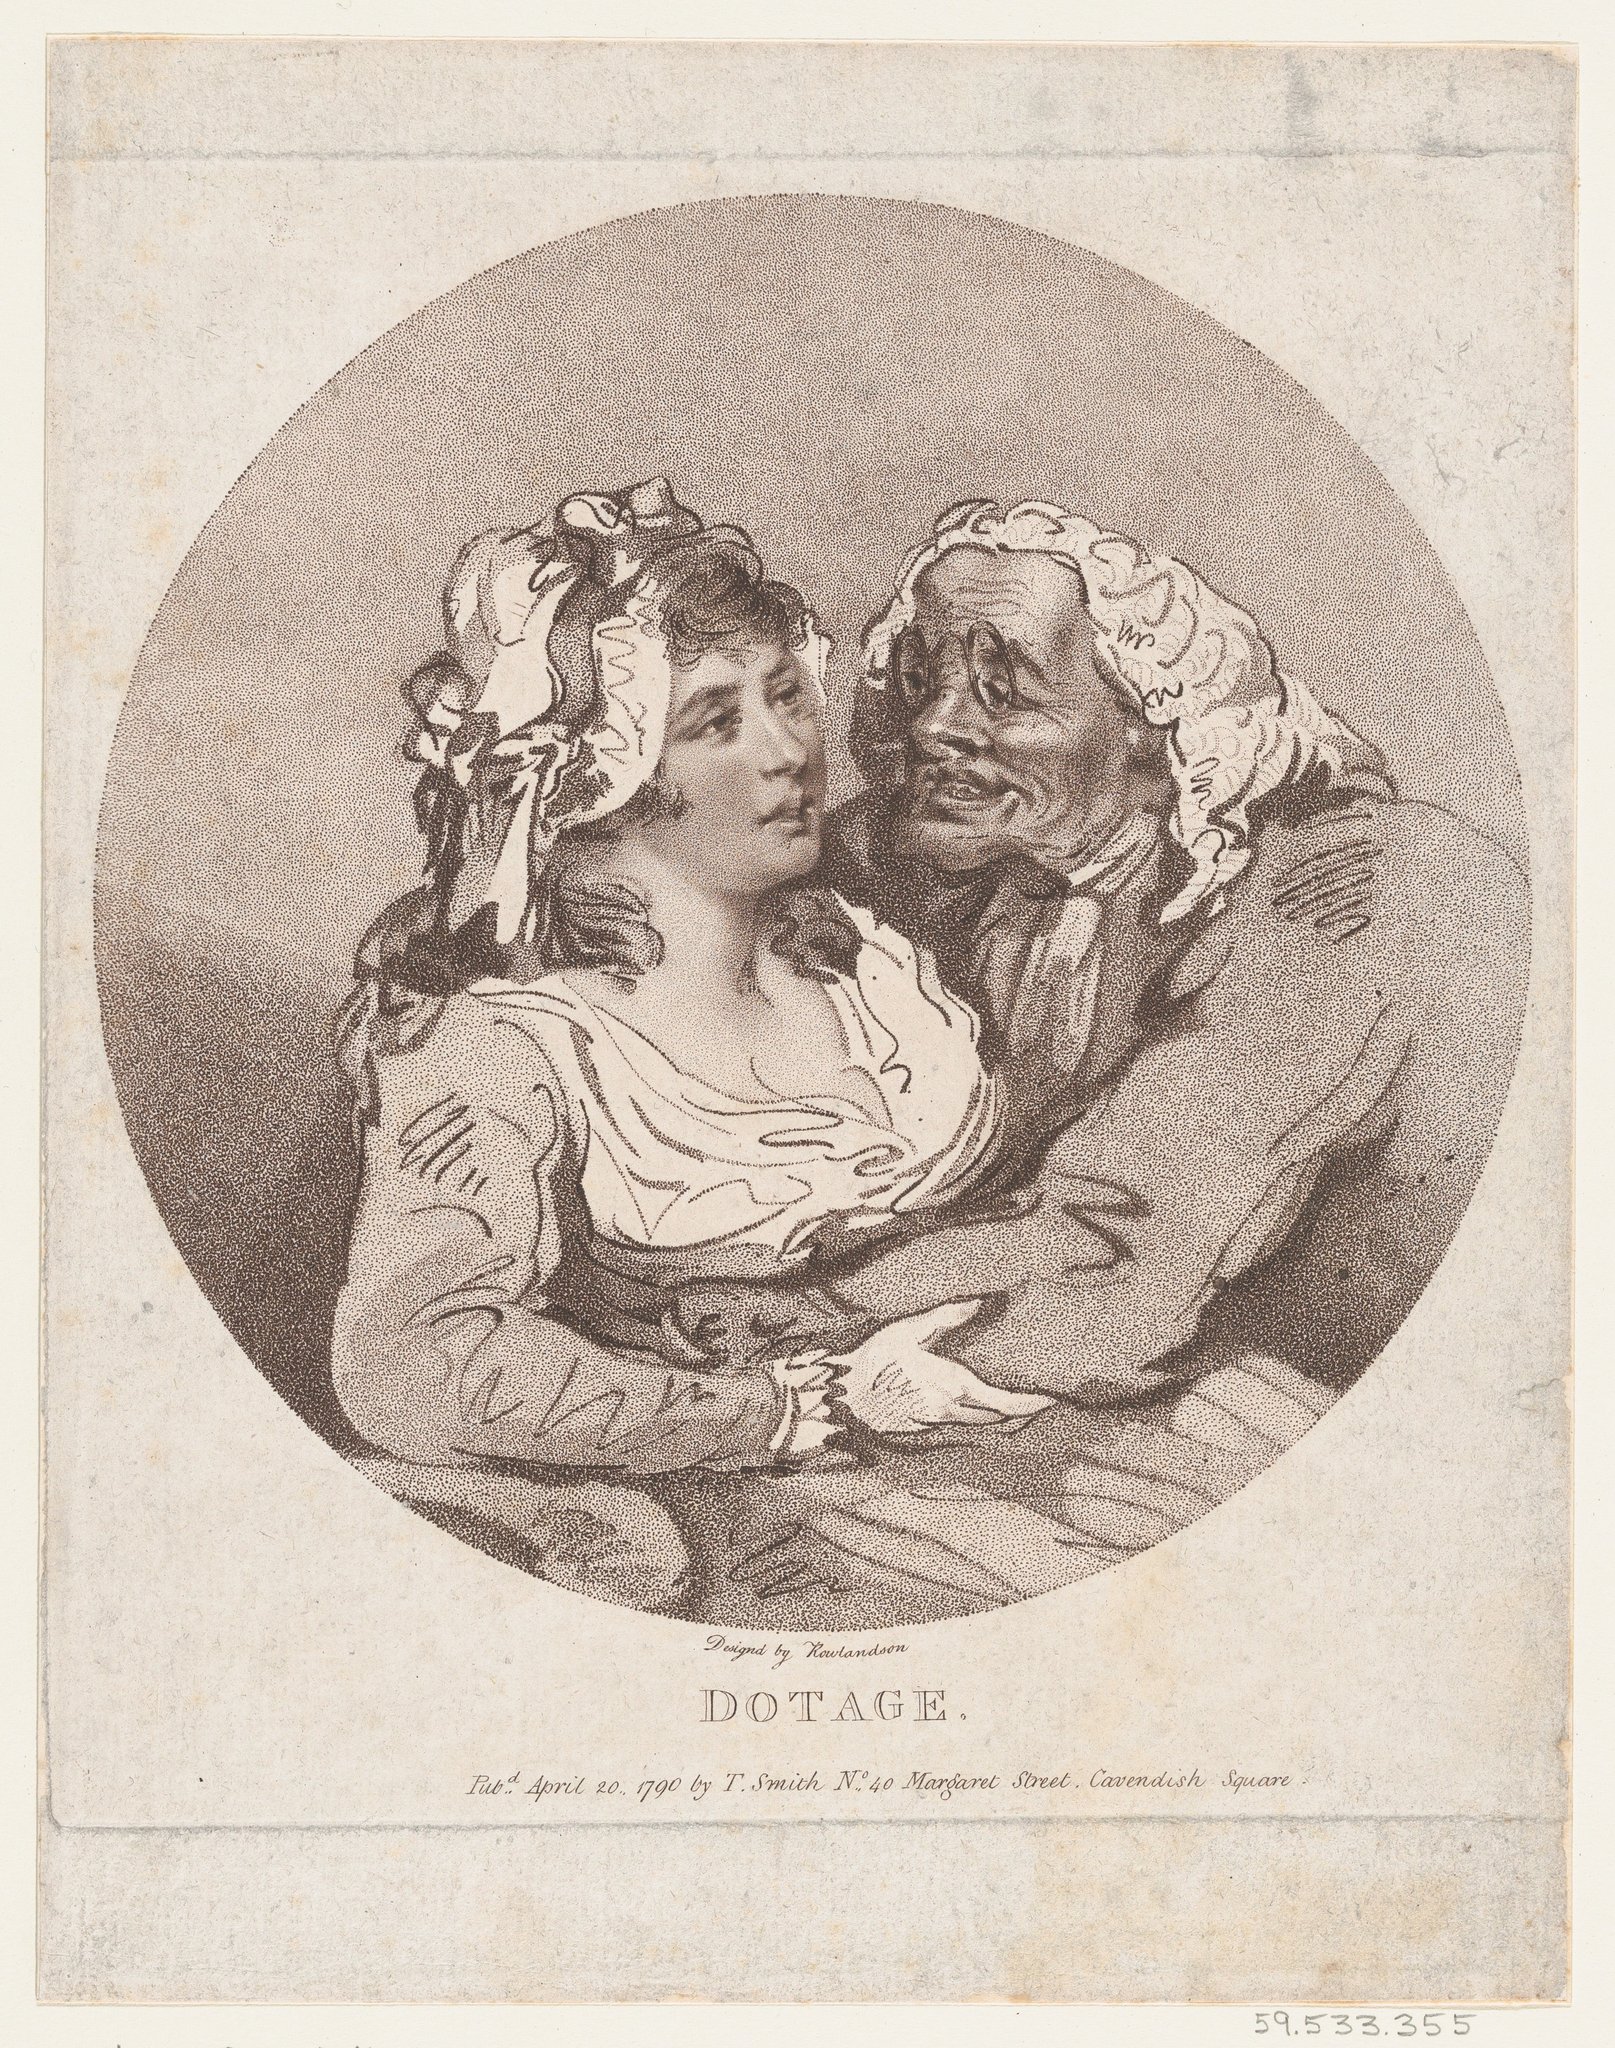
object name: print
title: Dotage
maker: t. smith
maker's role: etcher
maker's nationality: british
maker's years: 1785-1787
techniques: aquatint, etching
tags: men,women